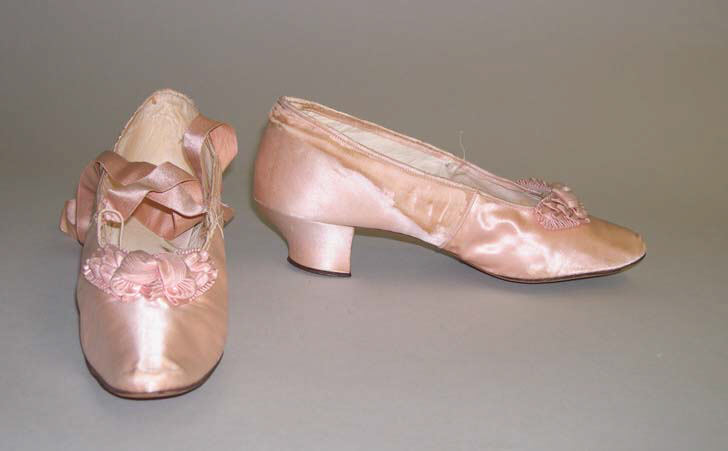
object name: pump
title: Pumps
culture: american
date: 1885-1890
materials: silk